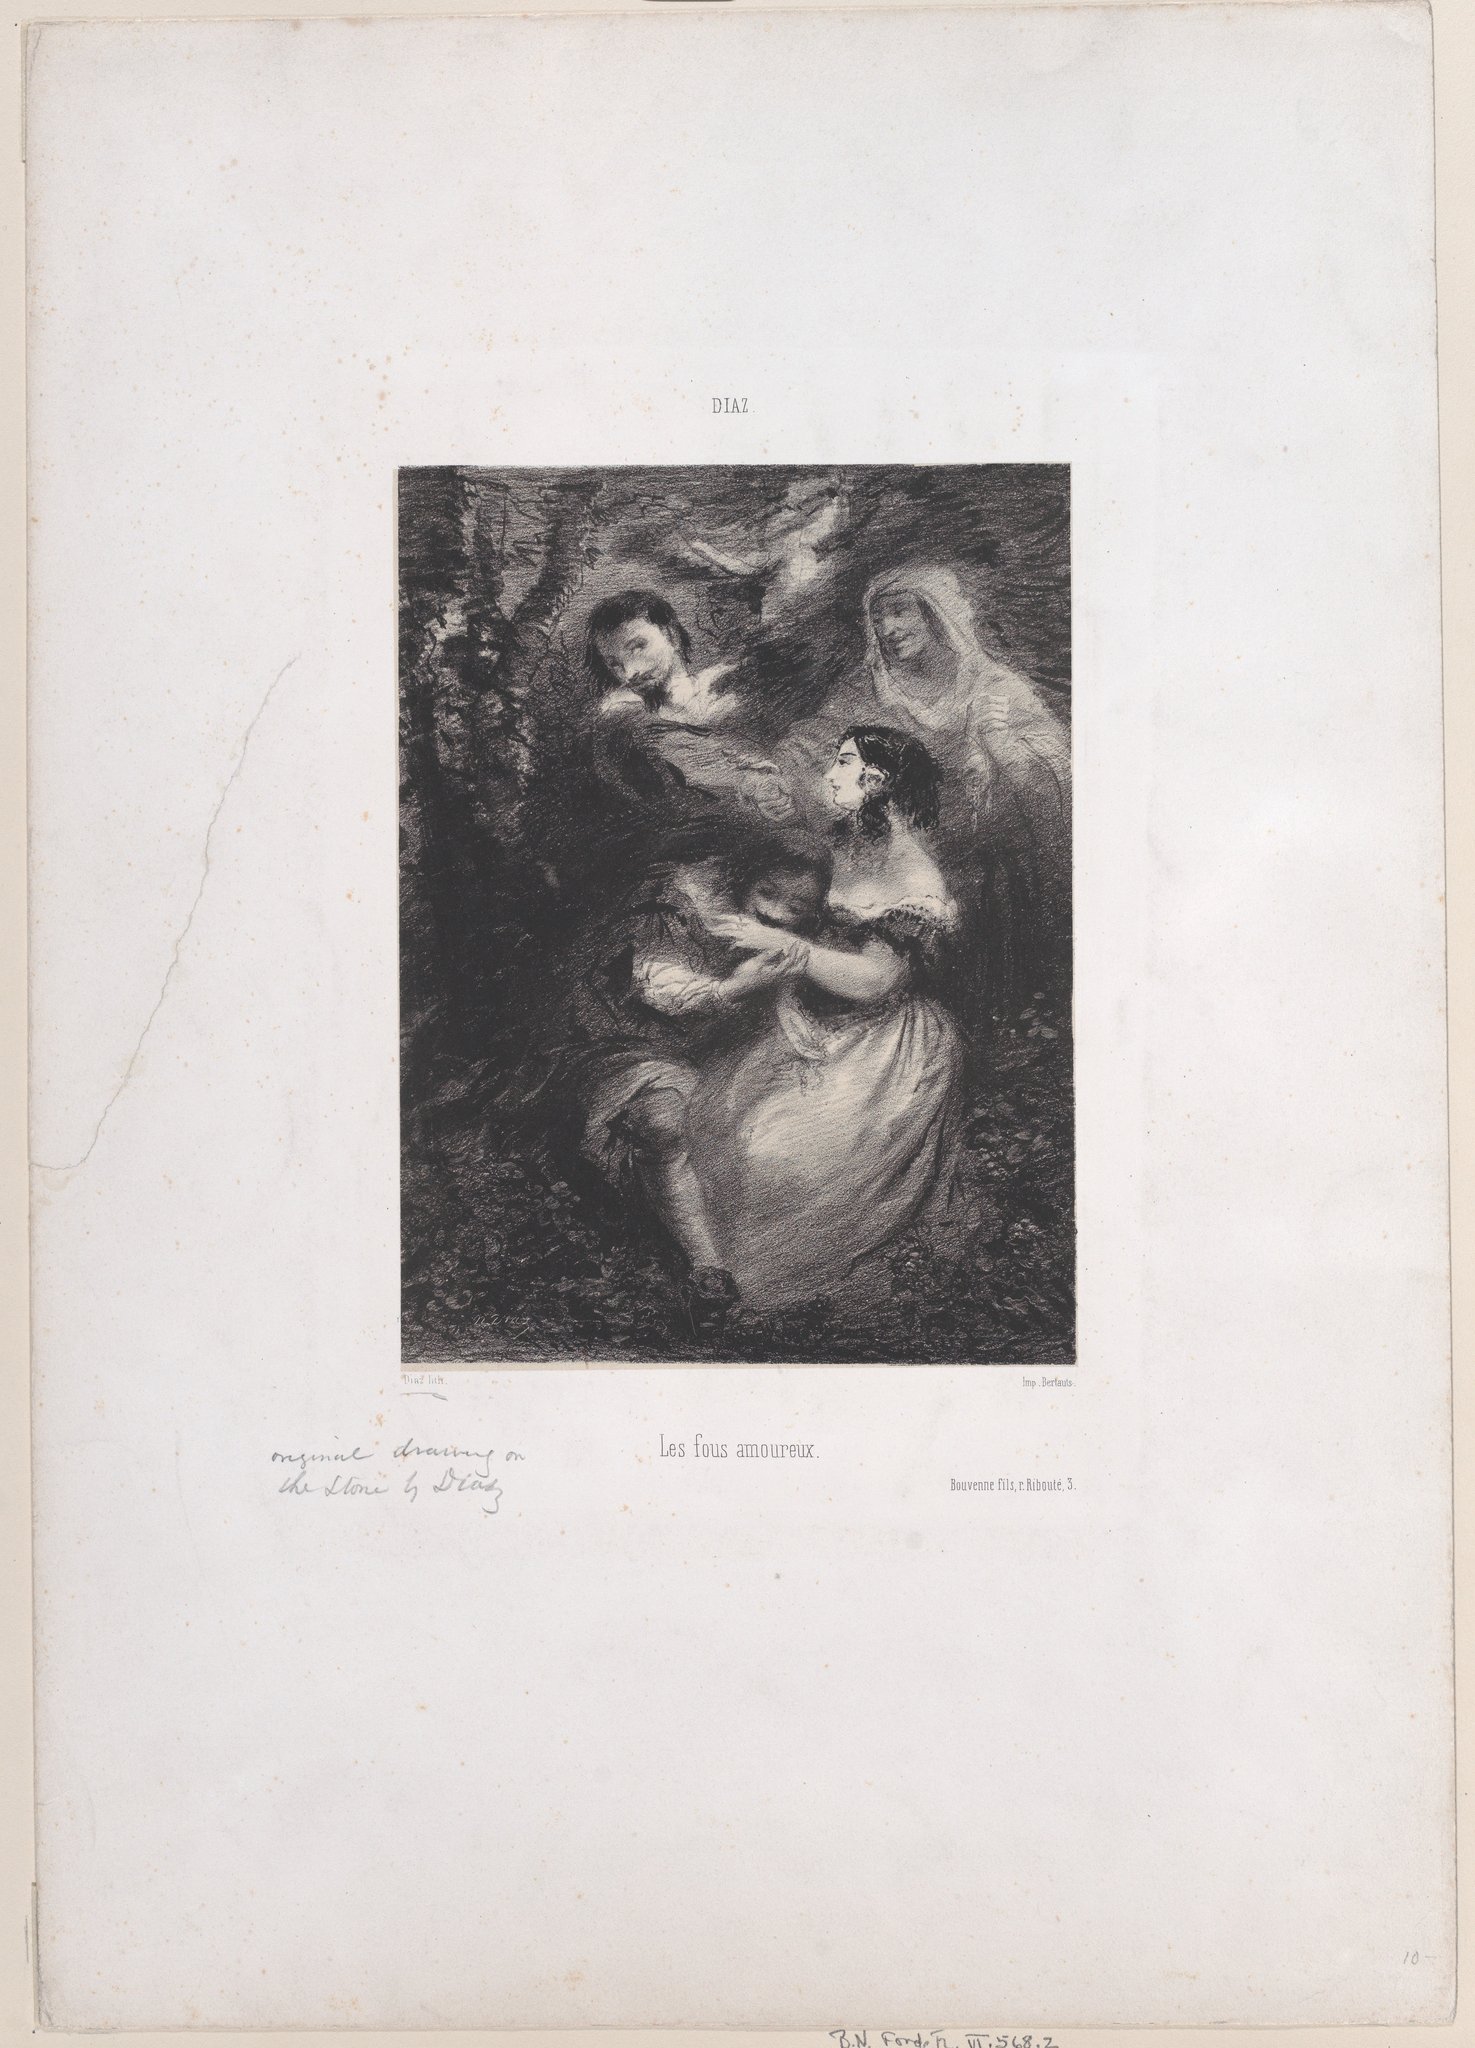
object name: print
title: Les fous amoureux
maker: narcisse-virgile diaz de la peña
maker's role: artist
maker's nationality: french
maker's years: 1808-1876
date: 1830-1876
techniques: lithograph